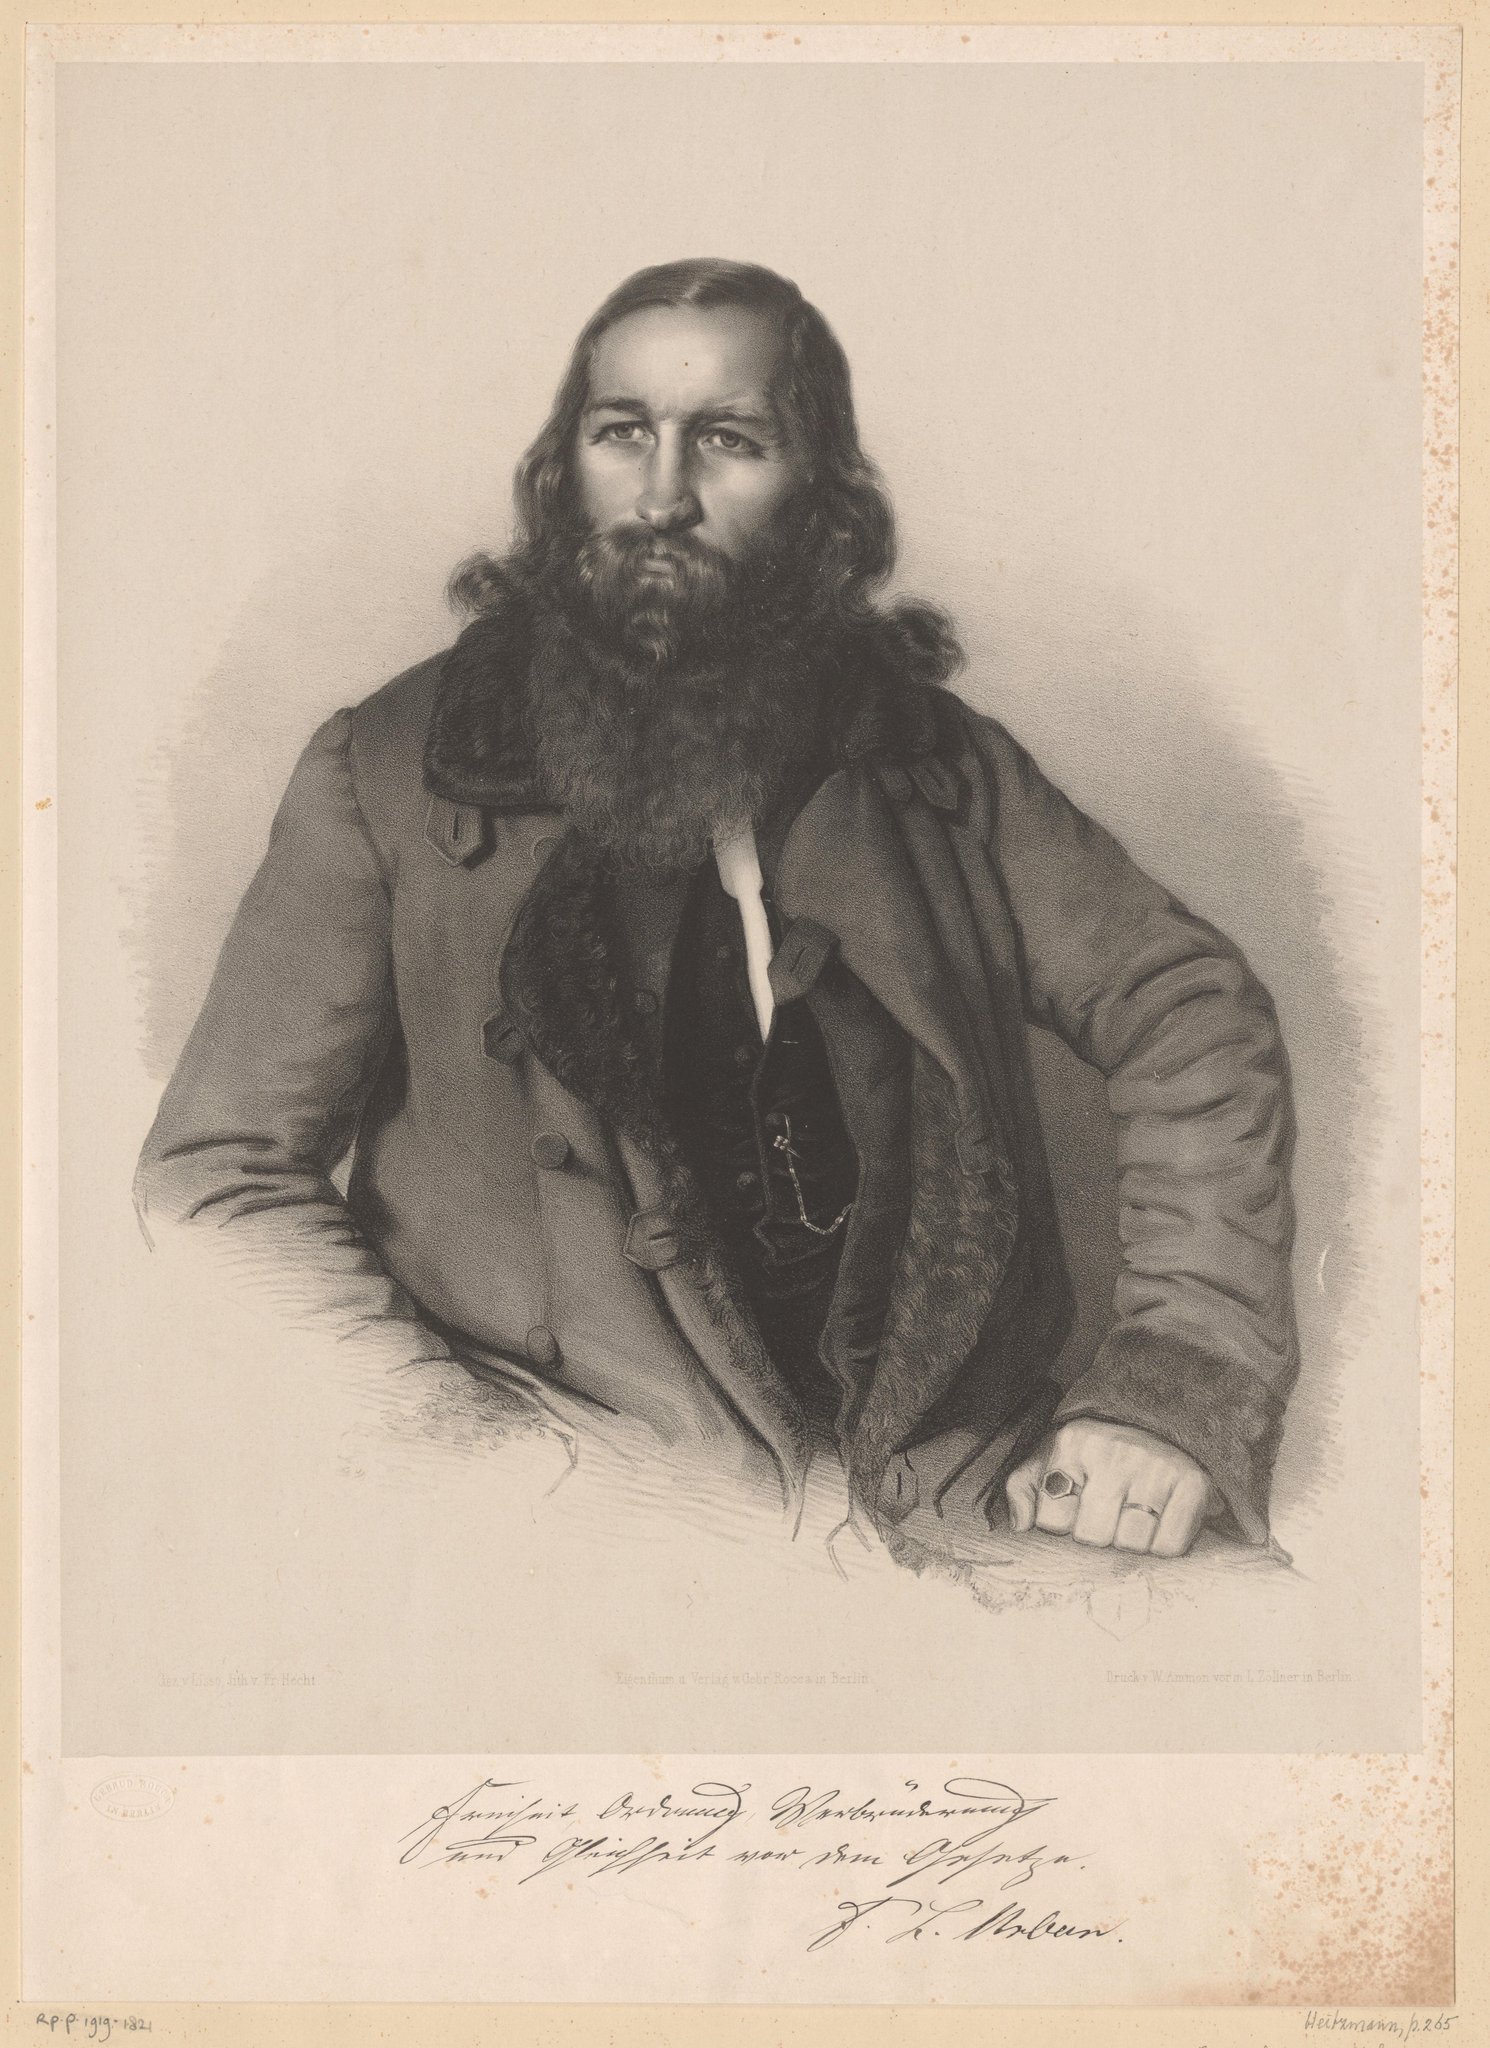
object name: print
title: Portret van een onbekende man, mogelijk F.L. Urban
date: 1875-1905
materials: paper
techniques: lithograph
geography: berlin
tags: adult man, historical persons, beard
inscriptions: collector's mark: Lugt 2228, check stamp: Lugt 2141c